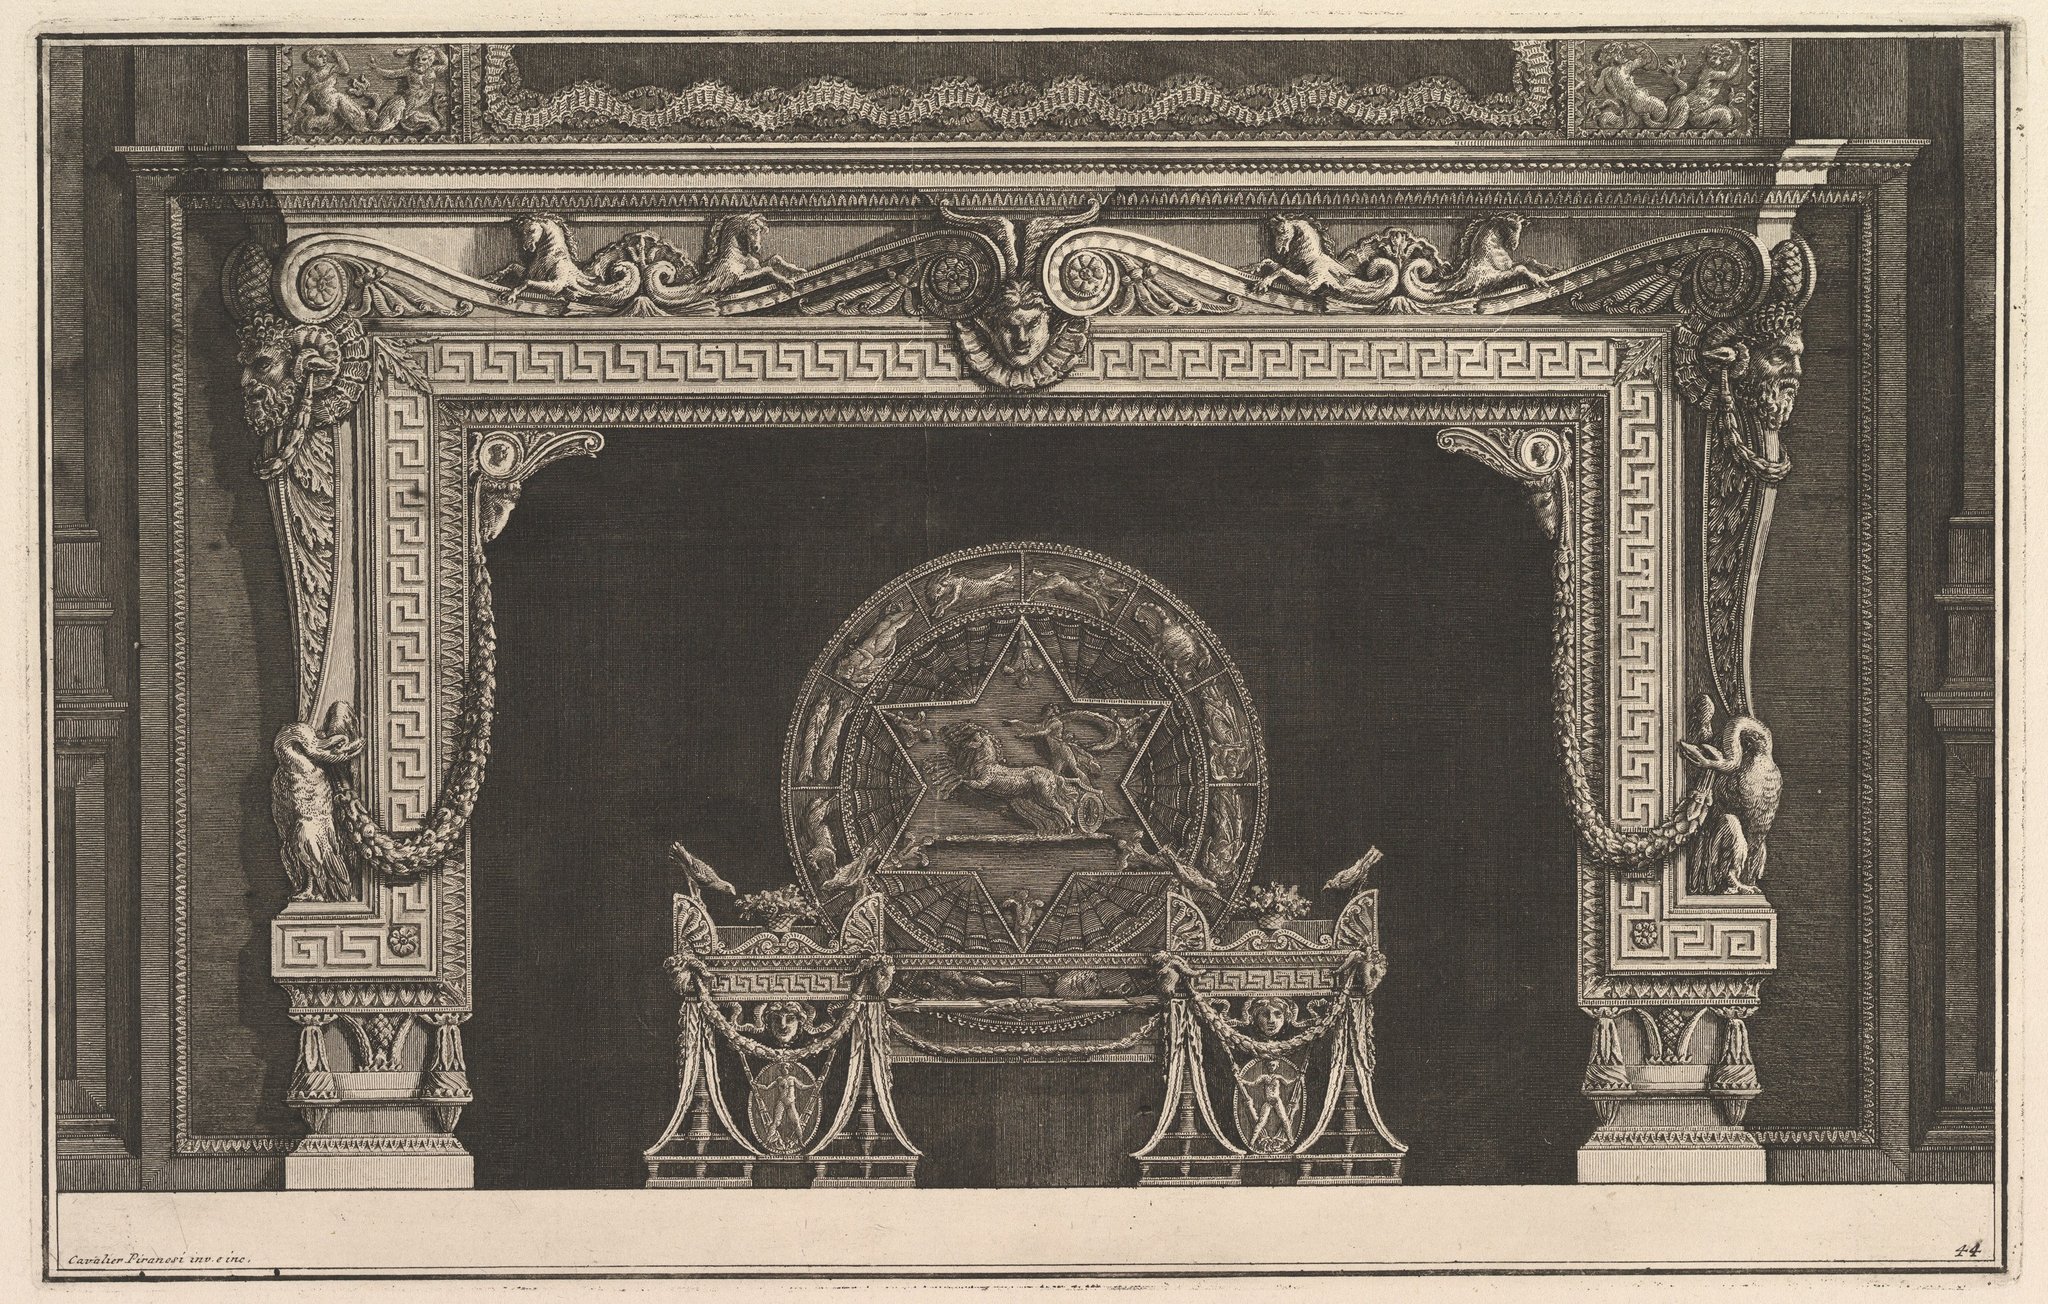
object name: print ornament architecture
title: Chimneypiece: Architrave decorated with a Greek key motif and a circular fireback with figures of the zodiac (Ch. décorée d'une grecque), from Diverse Maniere d'adornare i cammini ed ogni altra parte degli edifizi...(Different Ways of ornamenting chimneypieces and all other parts of houses)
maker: giovanni battista piranesi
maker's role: artist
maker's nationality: italian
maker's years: 1720-1778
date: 1769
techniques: etching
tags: fireplaces,zodiac